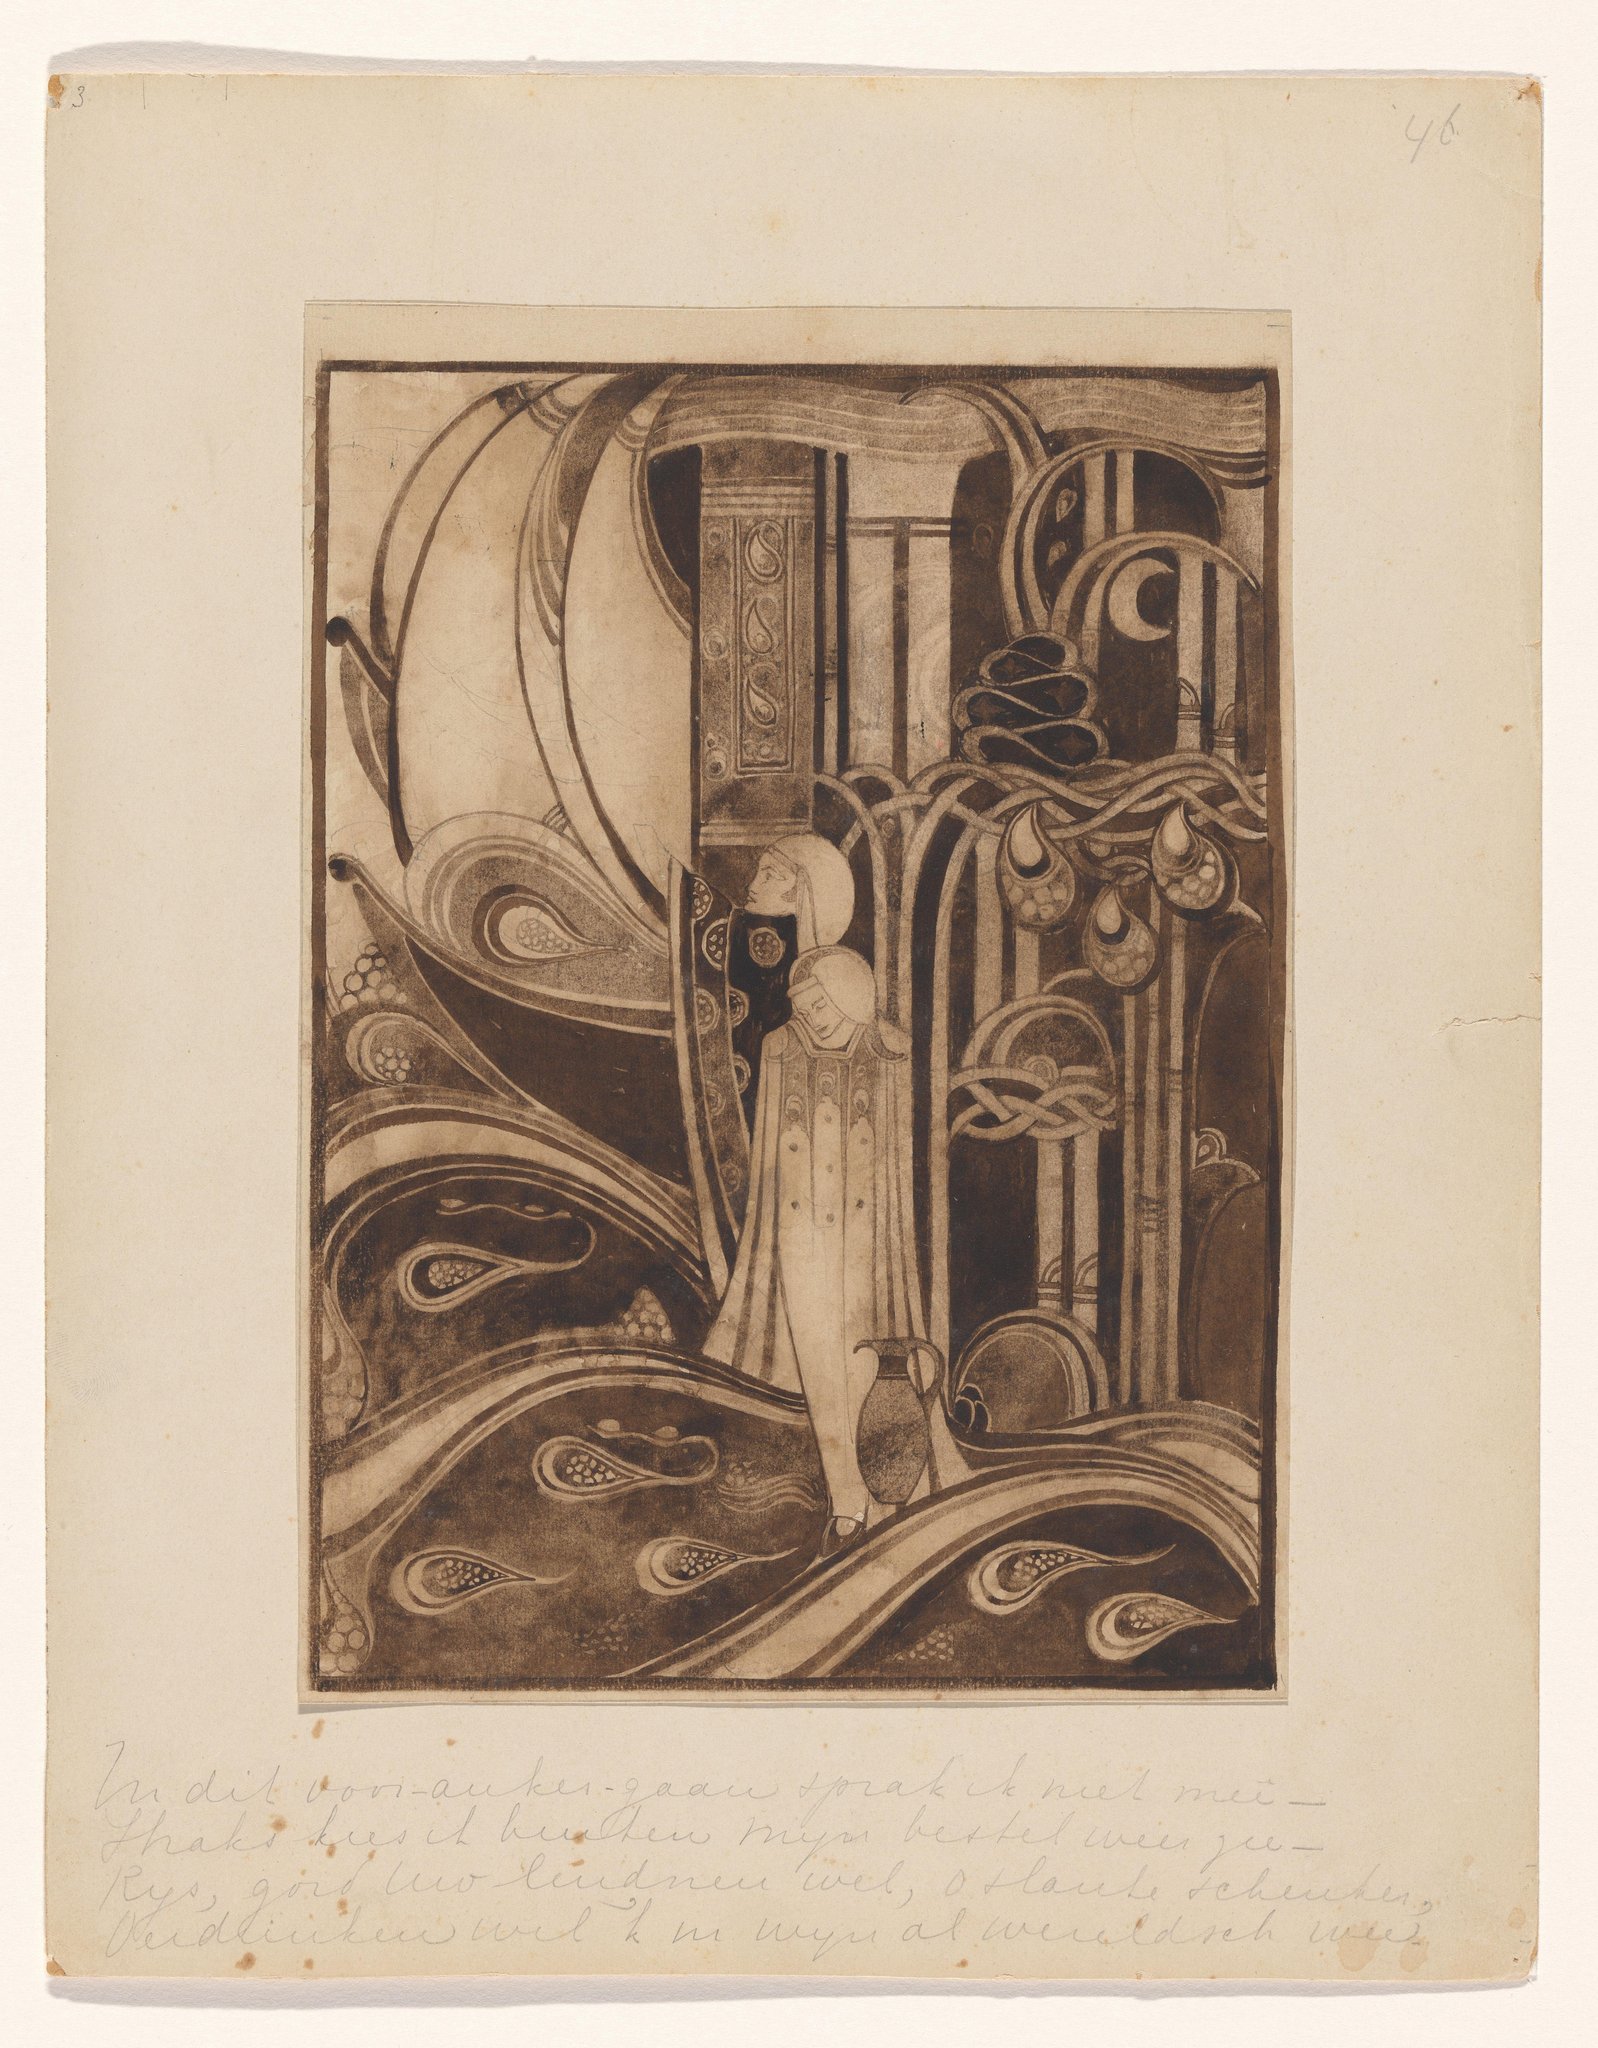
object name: drawing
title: Twee staande menselijke figuren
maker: willem arondéus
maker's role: draughtsman, print maker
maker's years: 1894-1943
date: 1914-1920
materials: cardboard, ink, paper, pencil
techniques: brush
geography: netherlands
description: Tekening naar de Rubaiyat van Omar Khayyam.